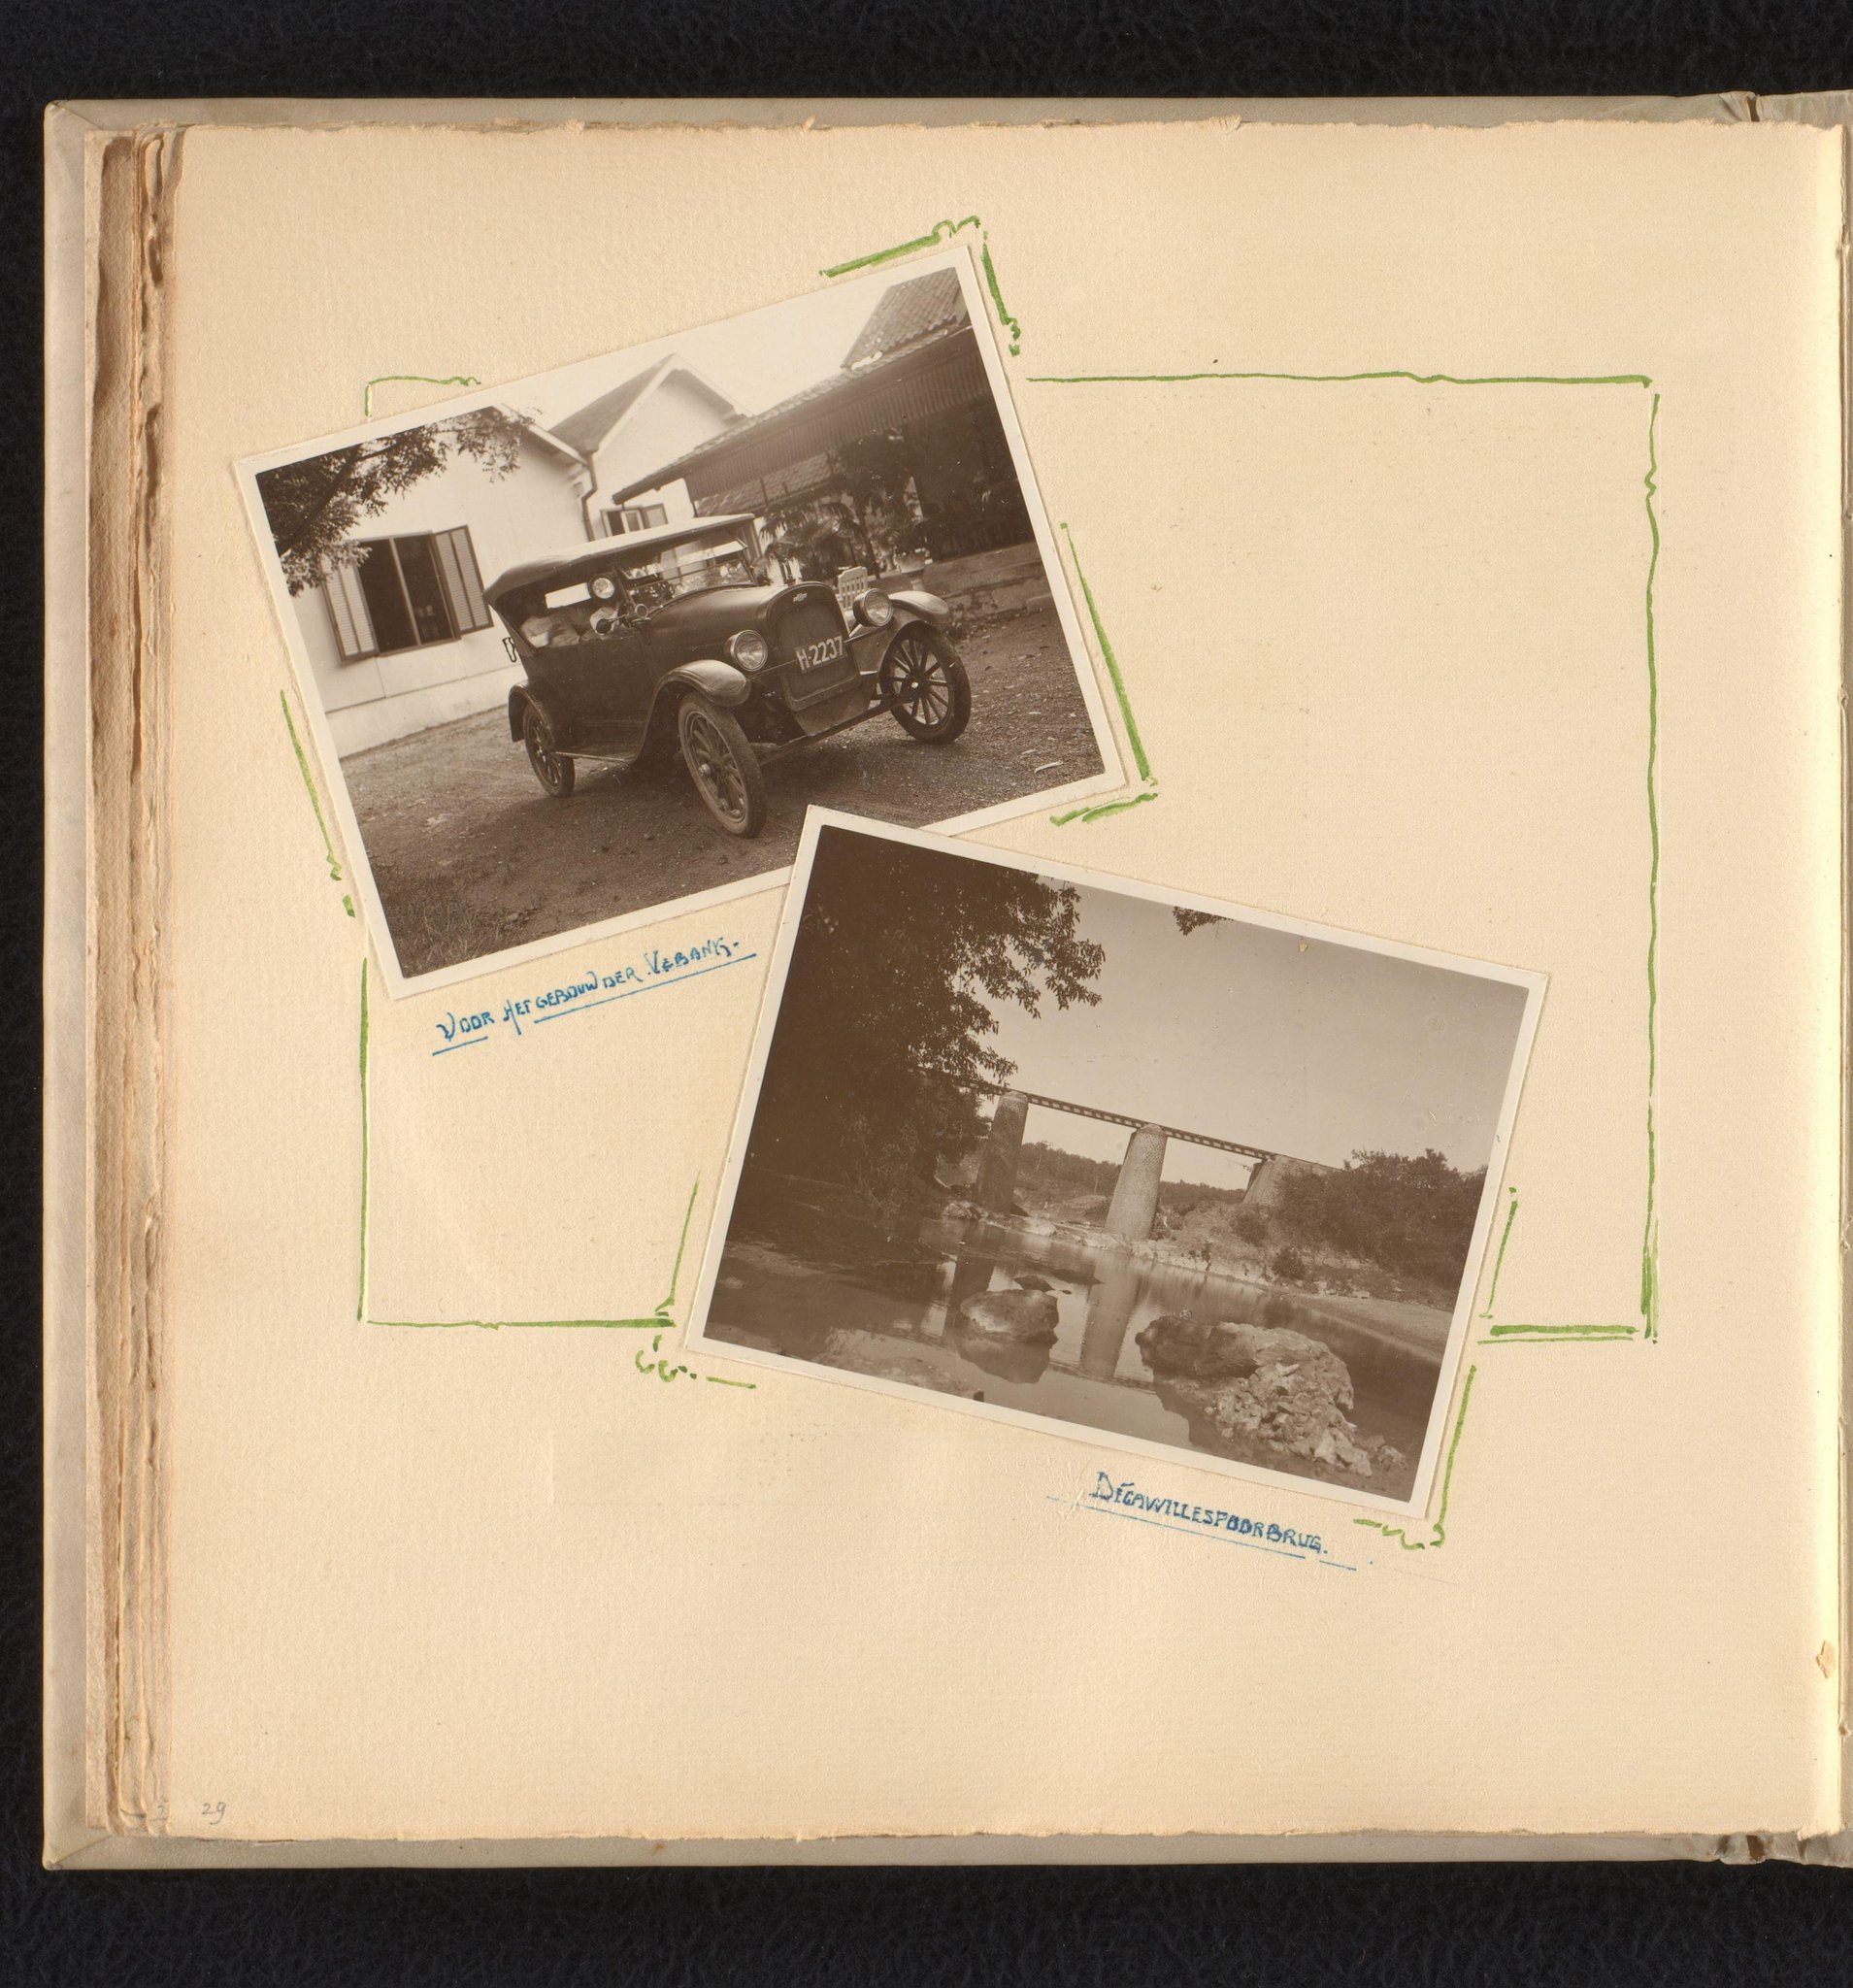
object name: photograph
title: Auto en spoorbrug in Grobogan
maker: Anonymous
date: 1910-1928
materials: paper, photographic support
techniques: drawing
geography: grobogan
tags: railway, train, automobile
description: Albumblad met twee foto's van een auto en een spoorbrug over een rivier in Grobogan. Het blad is versierd met randwerk om de foto's. Onderdeel van het fotoalbum aangeboden aan J. Habbema door het Binnenlandsch Bestuur Corps van het Regentschap Grobogan, bij het beëindigen van zijn bestuur over het Regentschap, waarschijnlijk in 1928.